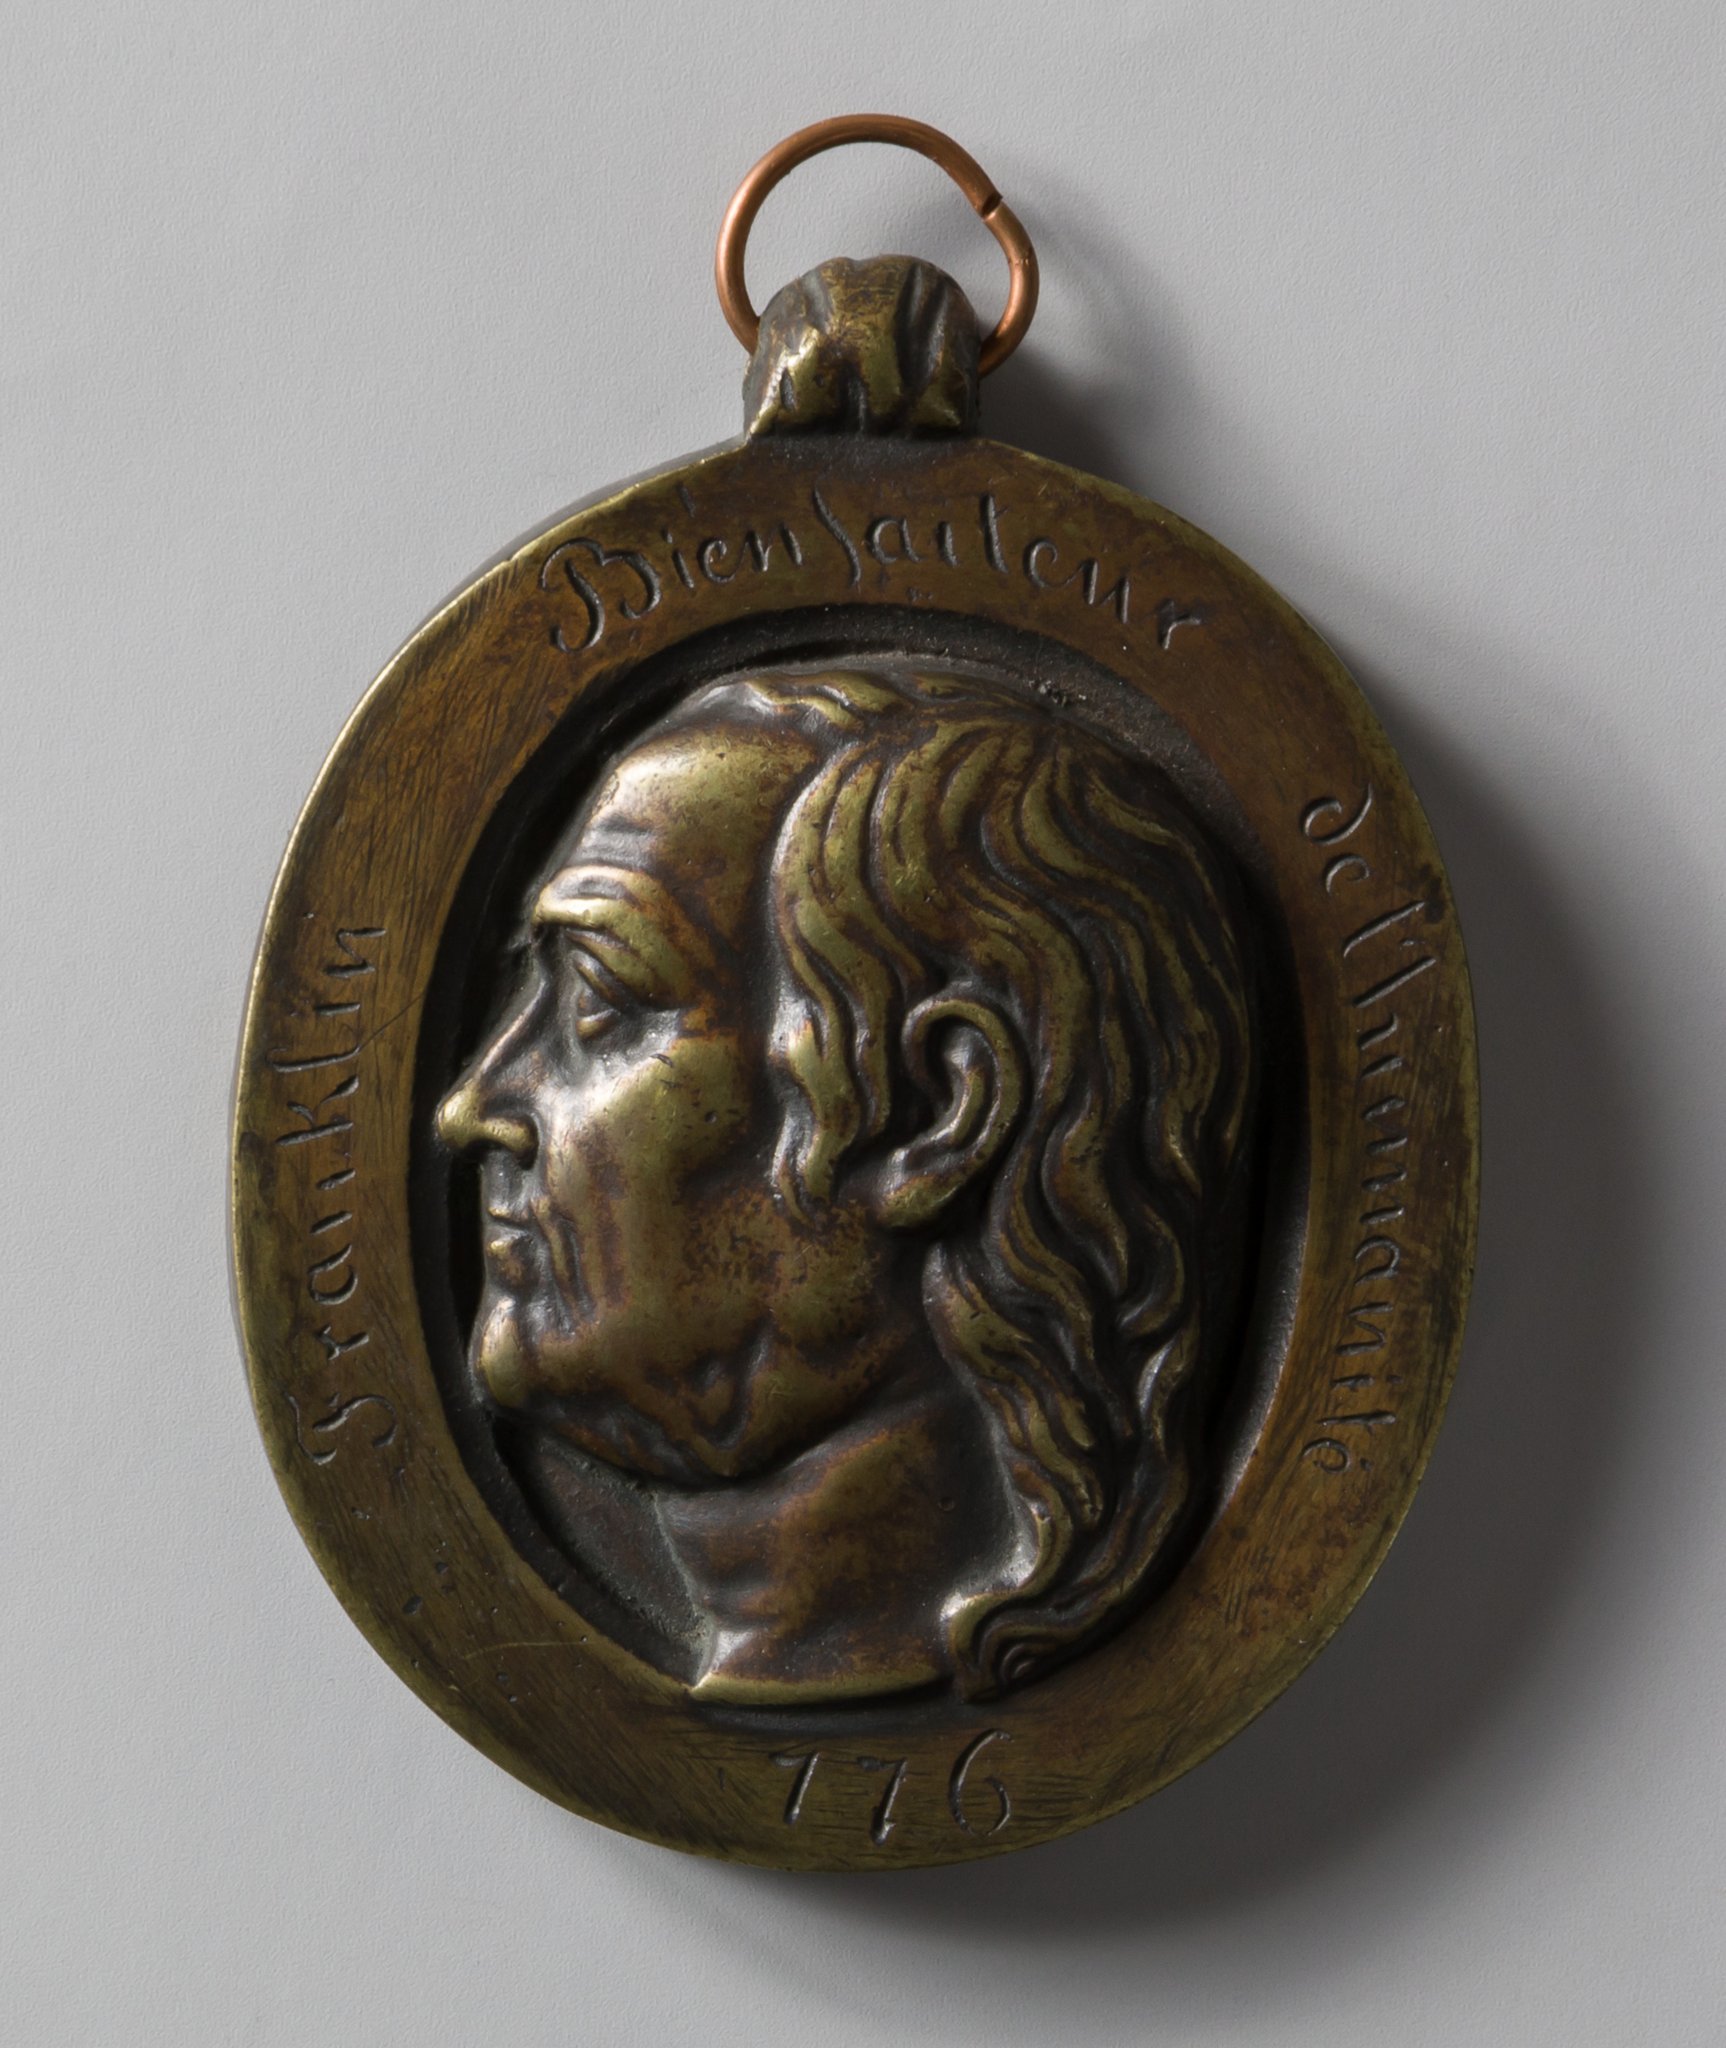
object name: medallion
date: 1870-1900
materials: bronze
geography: france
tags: men,portraits,profiles